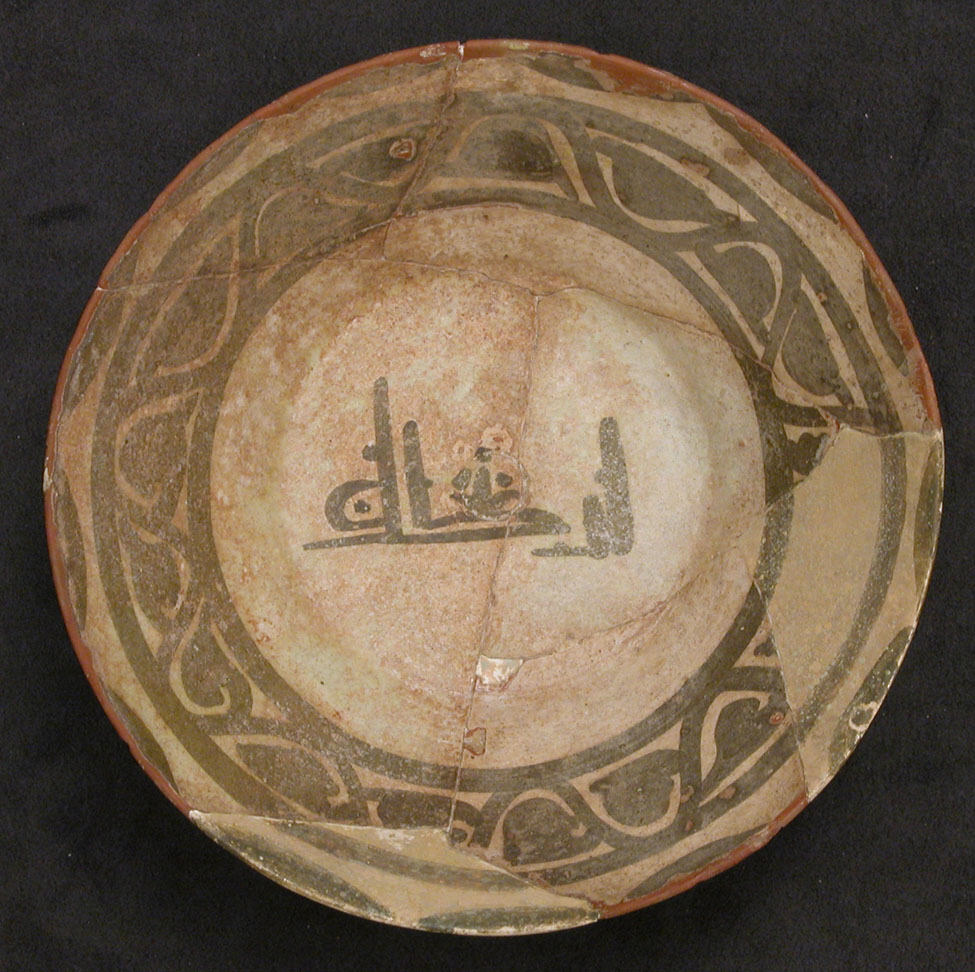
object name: bowl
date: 701-900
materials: earthenware, glaze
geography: iran